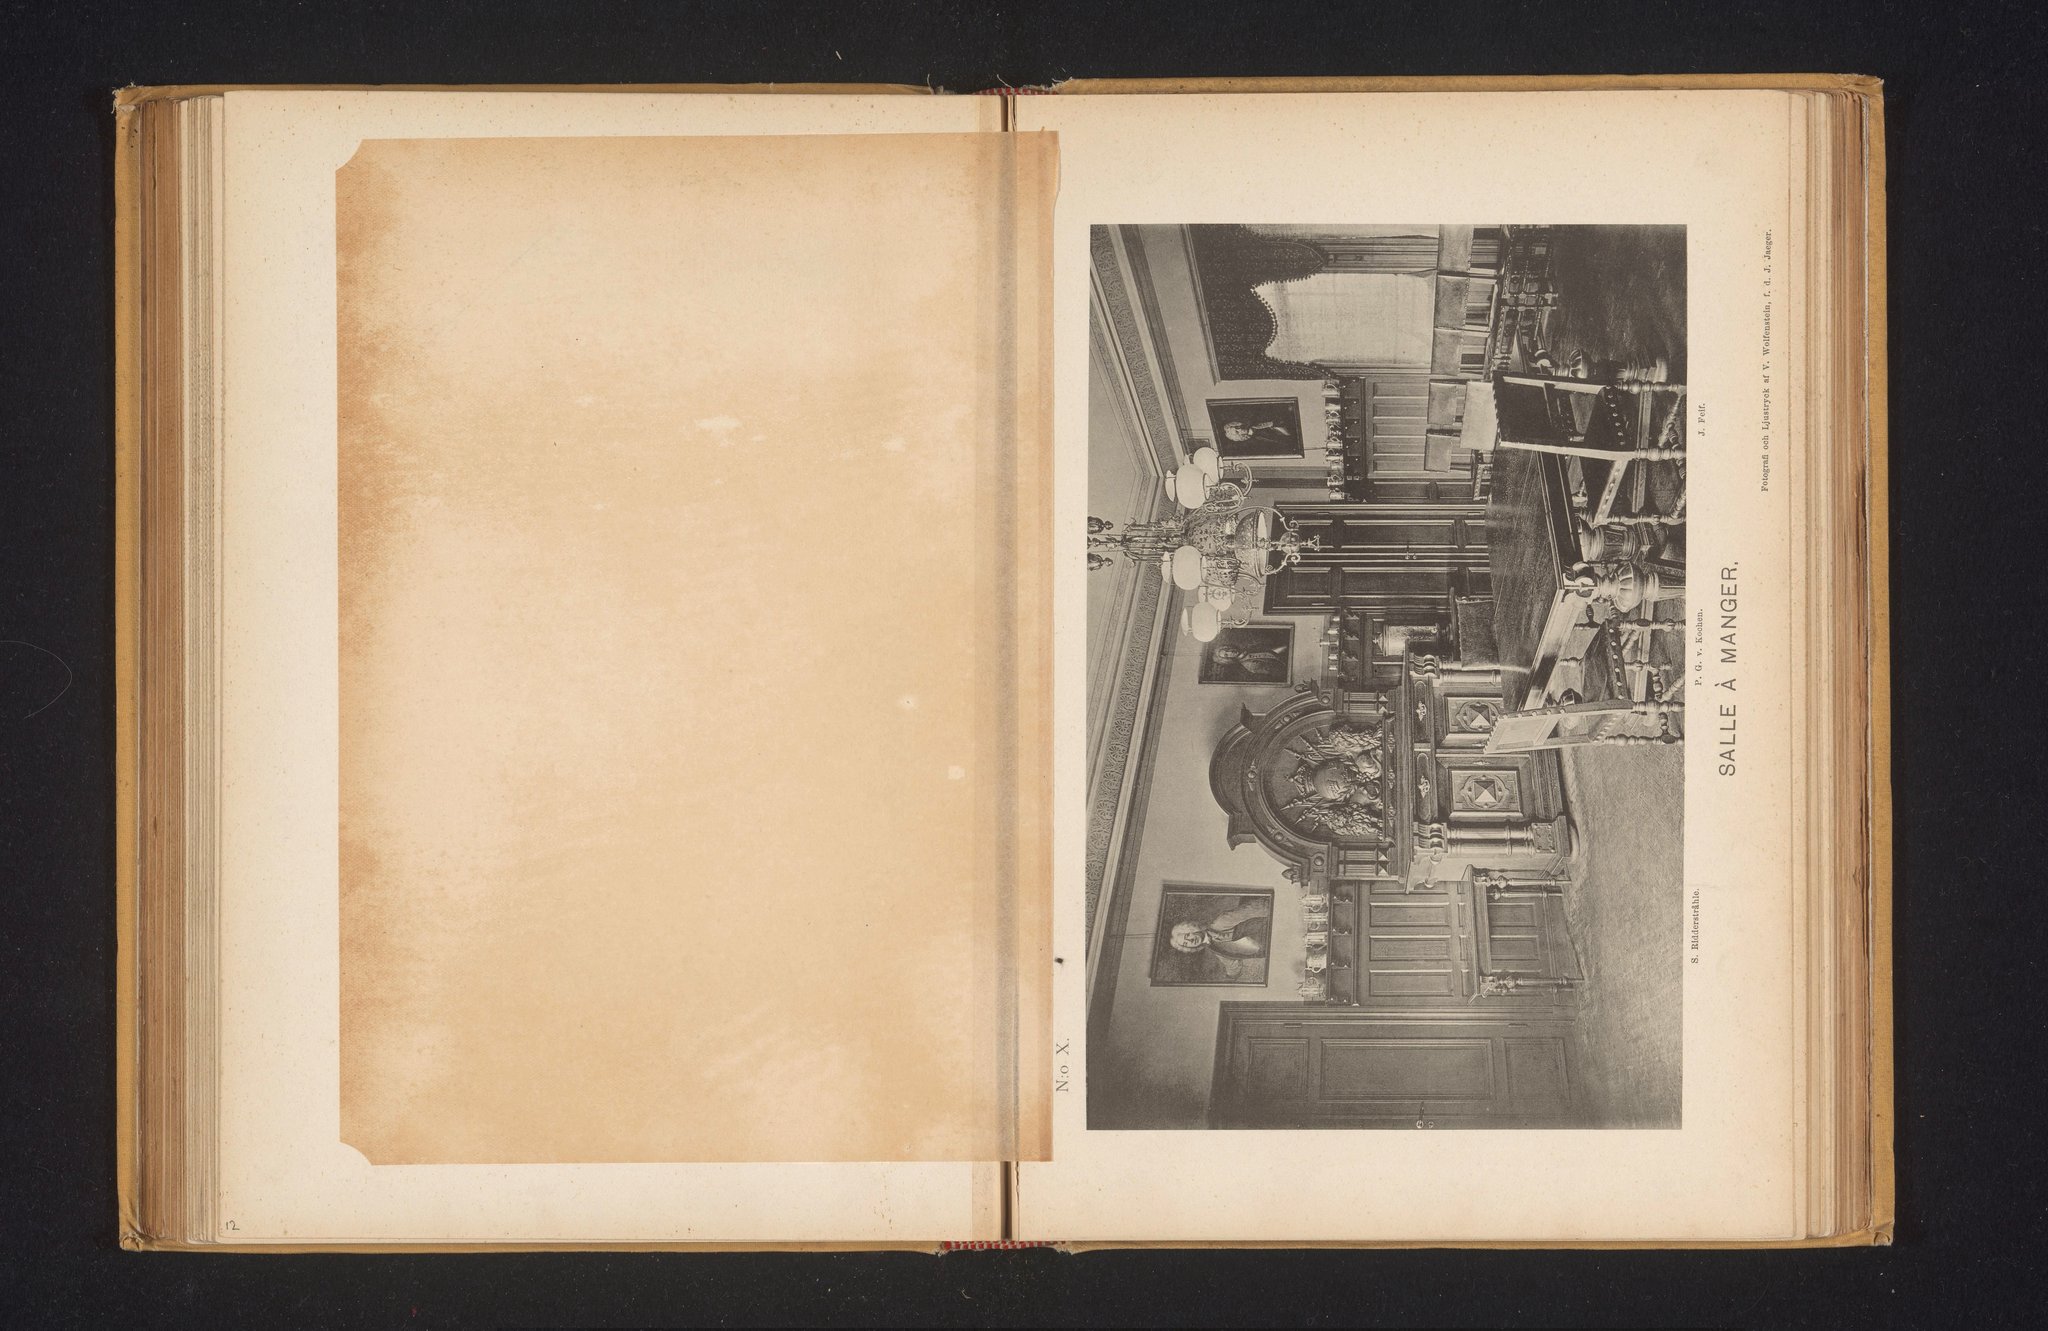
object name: photomechanical print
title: Salle à manger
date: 1888-1891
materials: paper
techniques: photograph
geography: stockholm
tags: dining-room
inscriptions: number: ‘N:o X.’